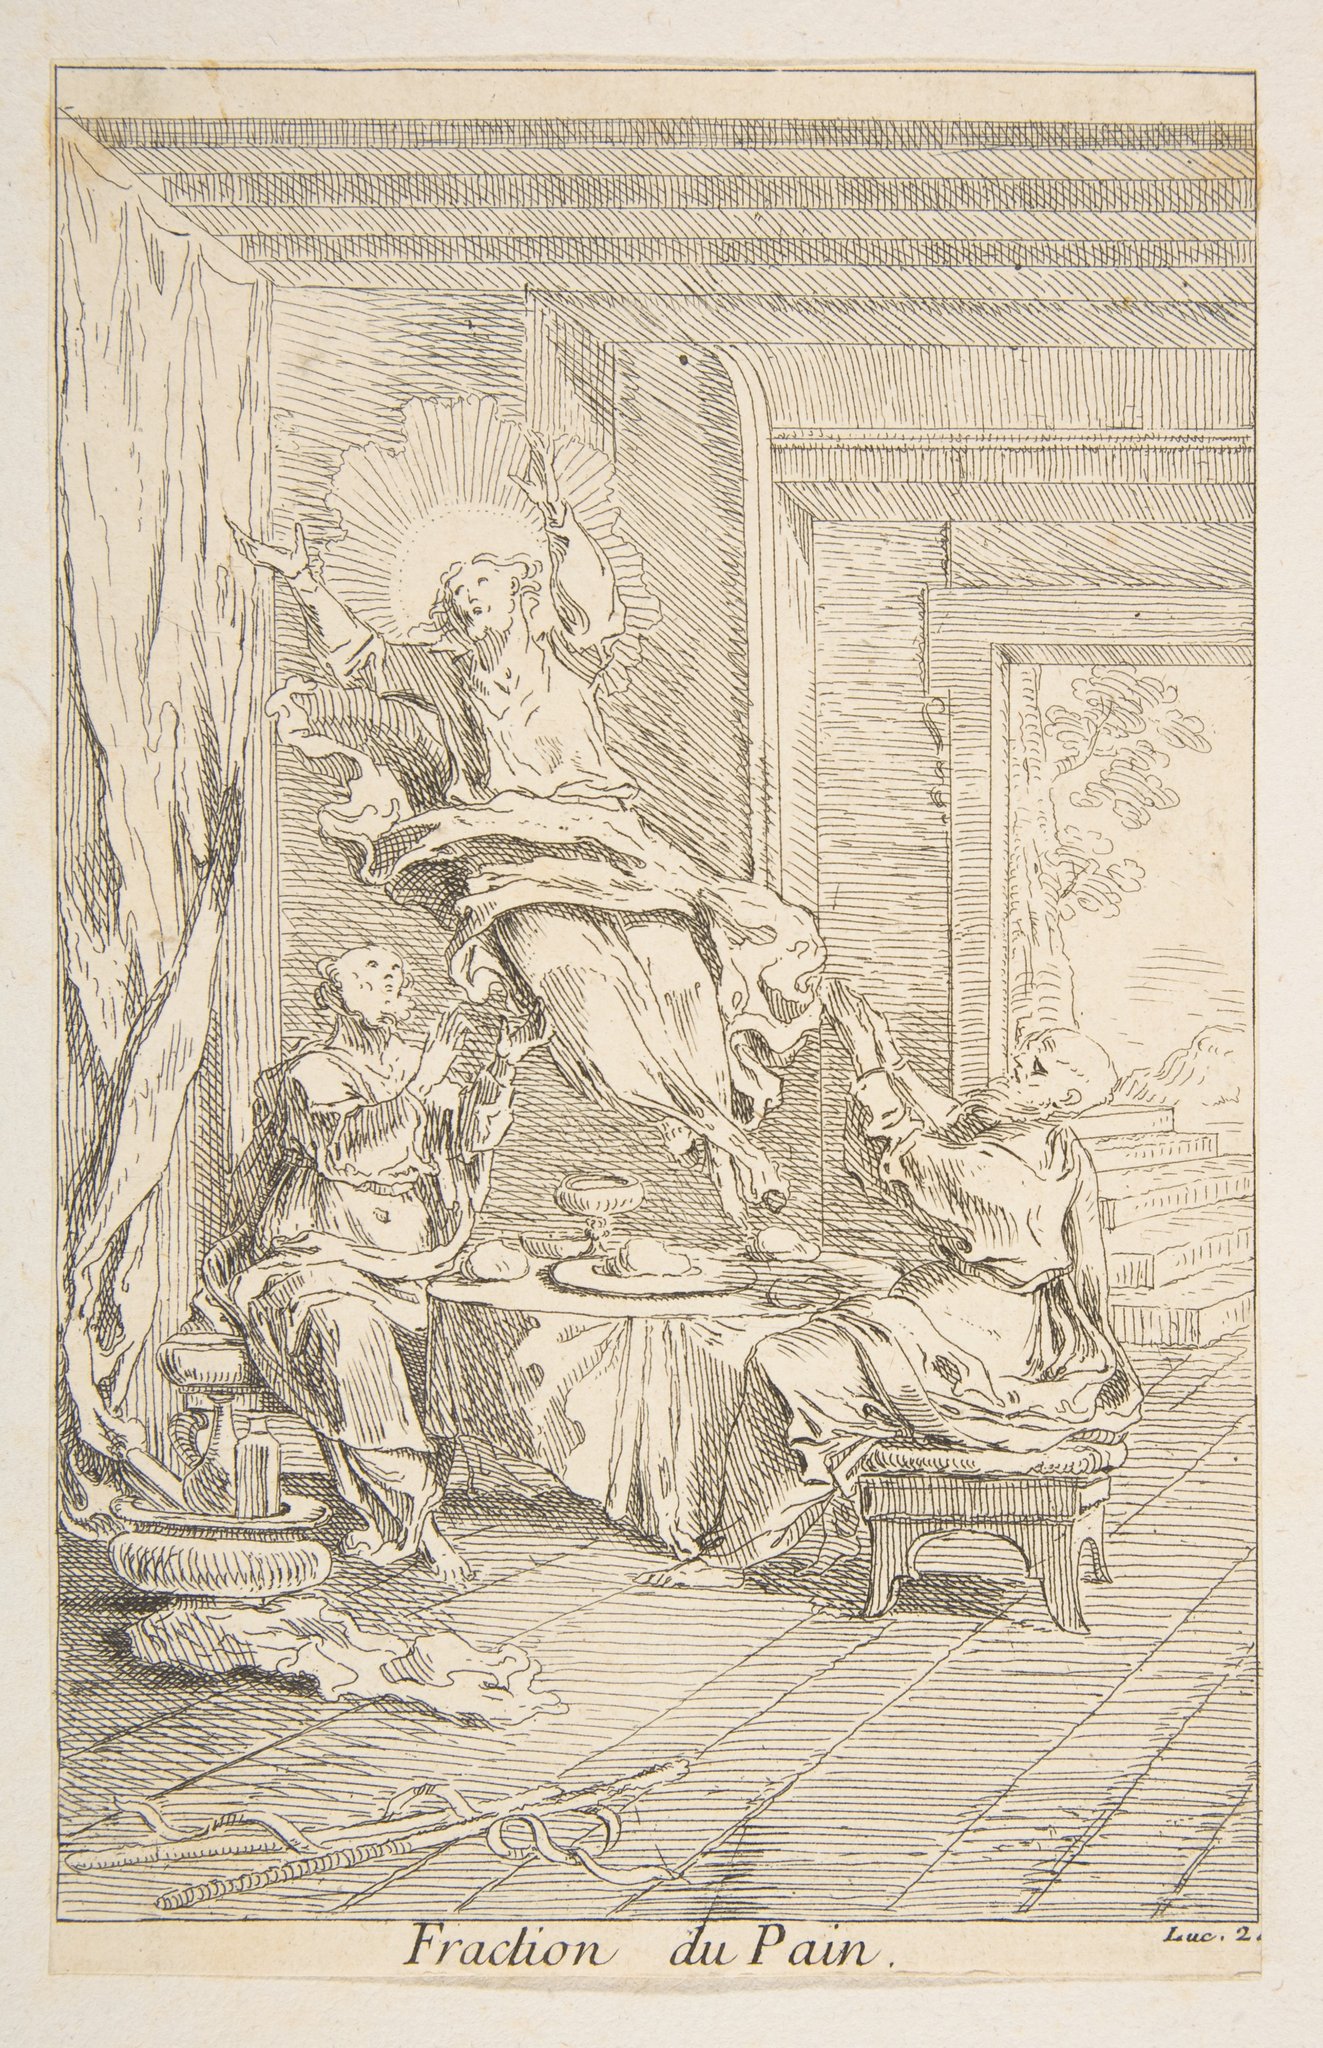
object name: print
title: Division of the Bread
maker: claude gillot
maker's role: artist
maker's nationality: french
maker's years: 1673-1722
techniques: etching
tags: men,christ